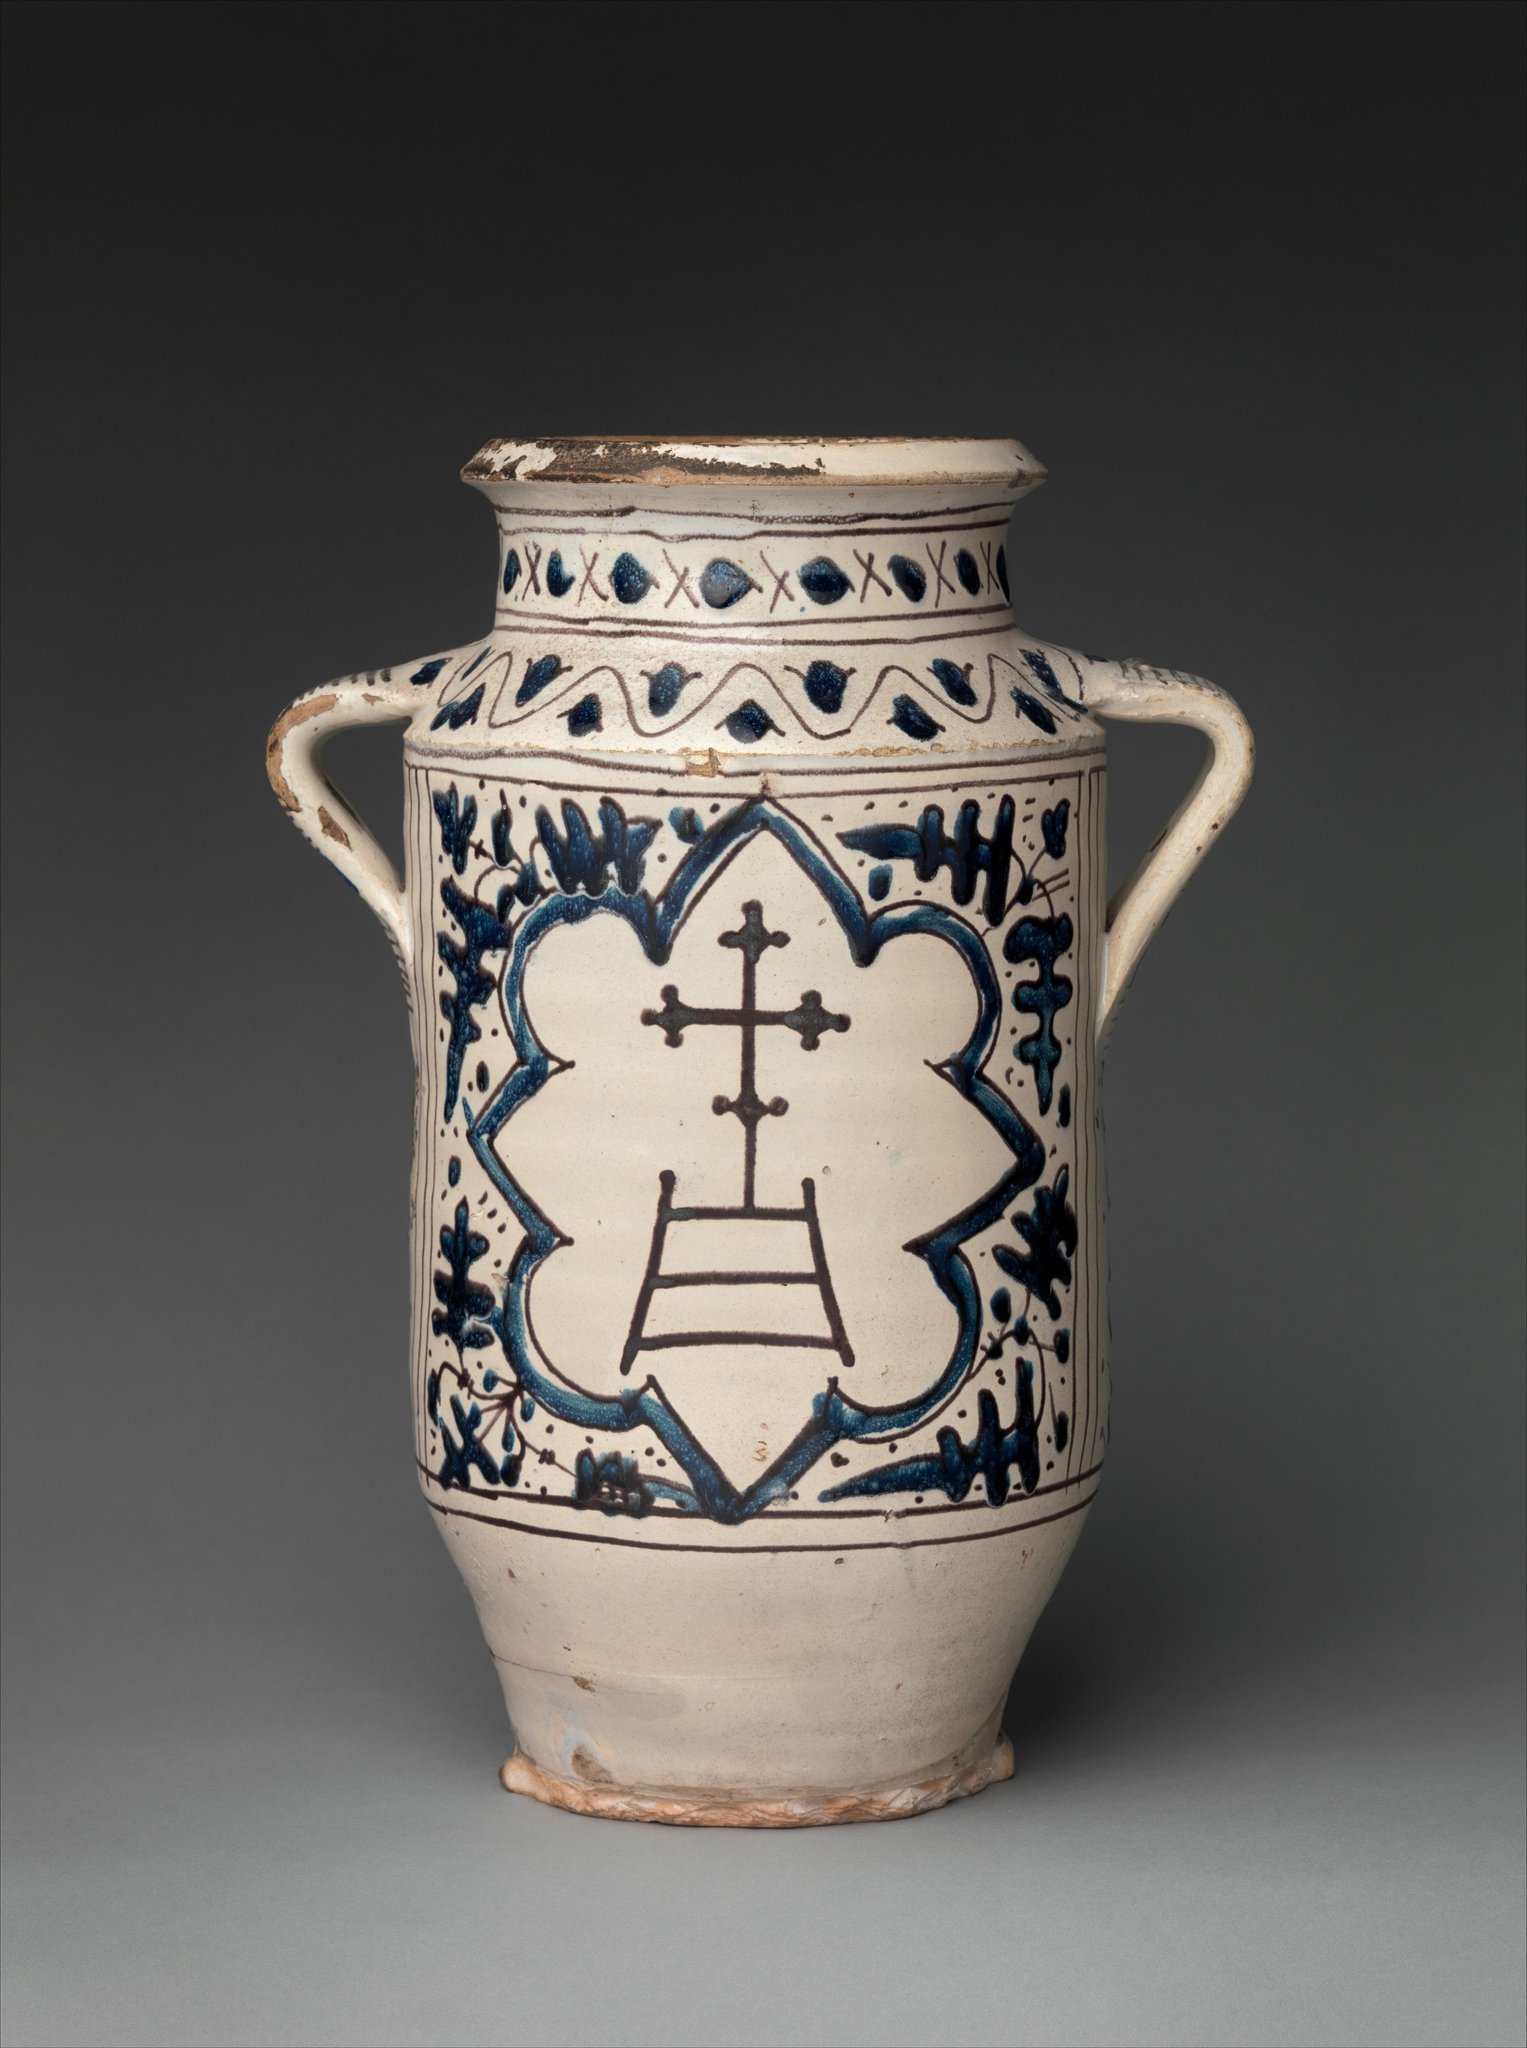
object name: pharmacy jar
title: Pharmacy Jar with the Arms of the Hospital of Santa Maria della Scala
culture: italian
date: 1425-1450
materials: earthenware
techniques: glazing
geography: italy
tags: cross